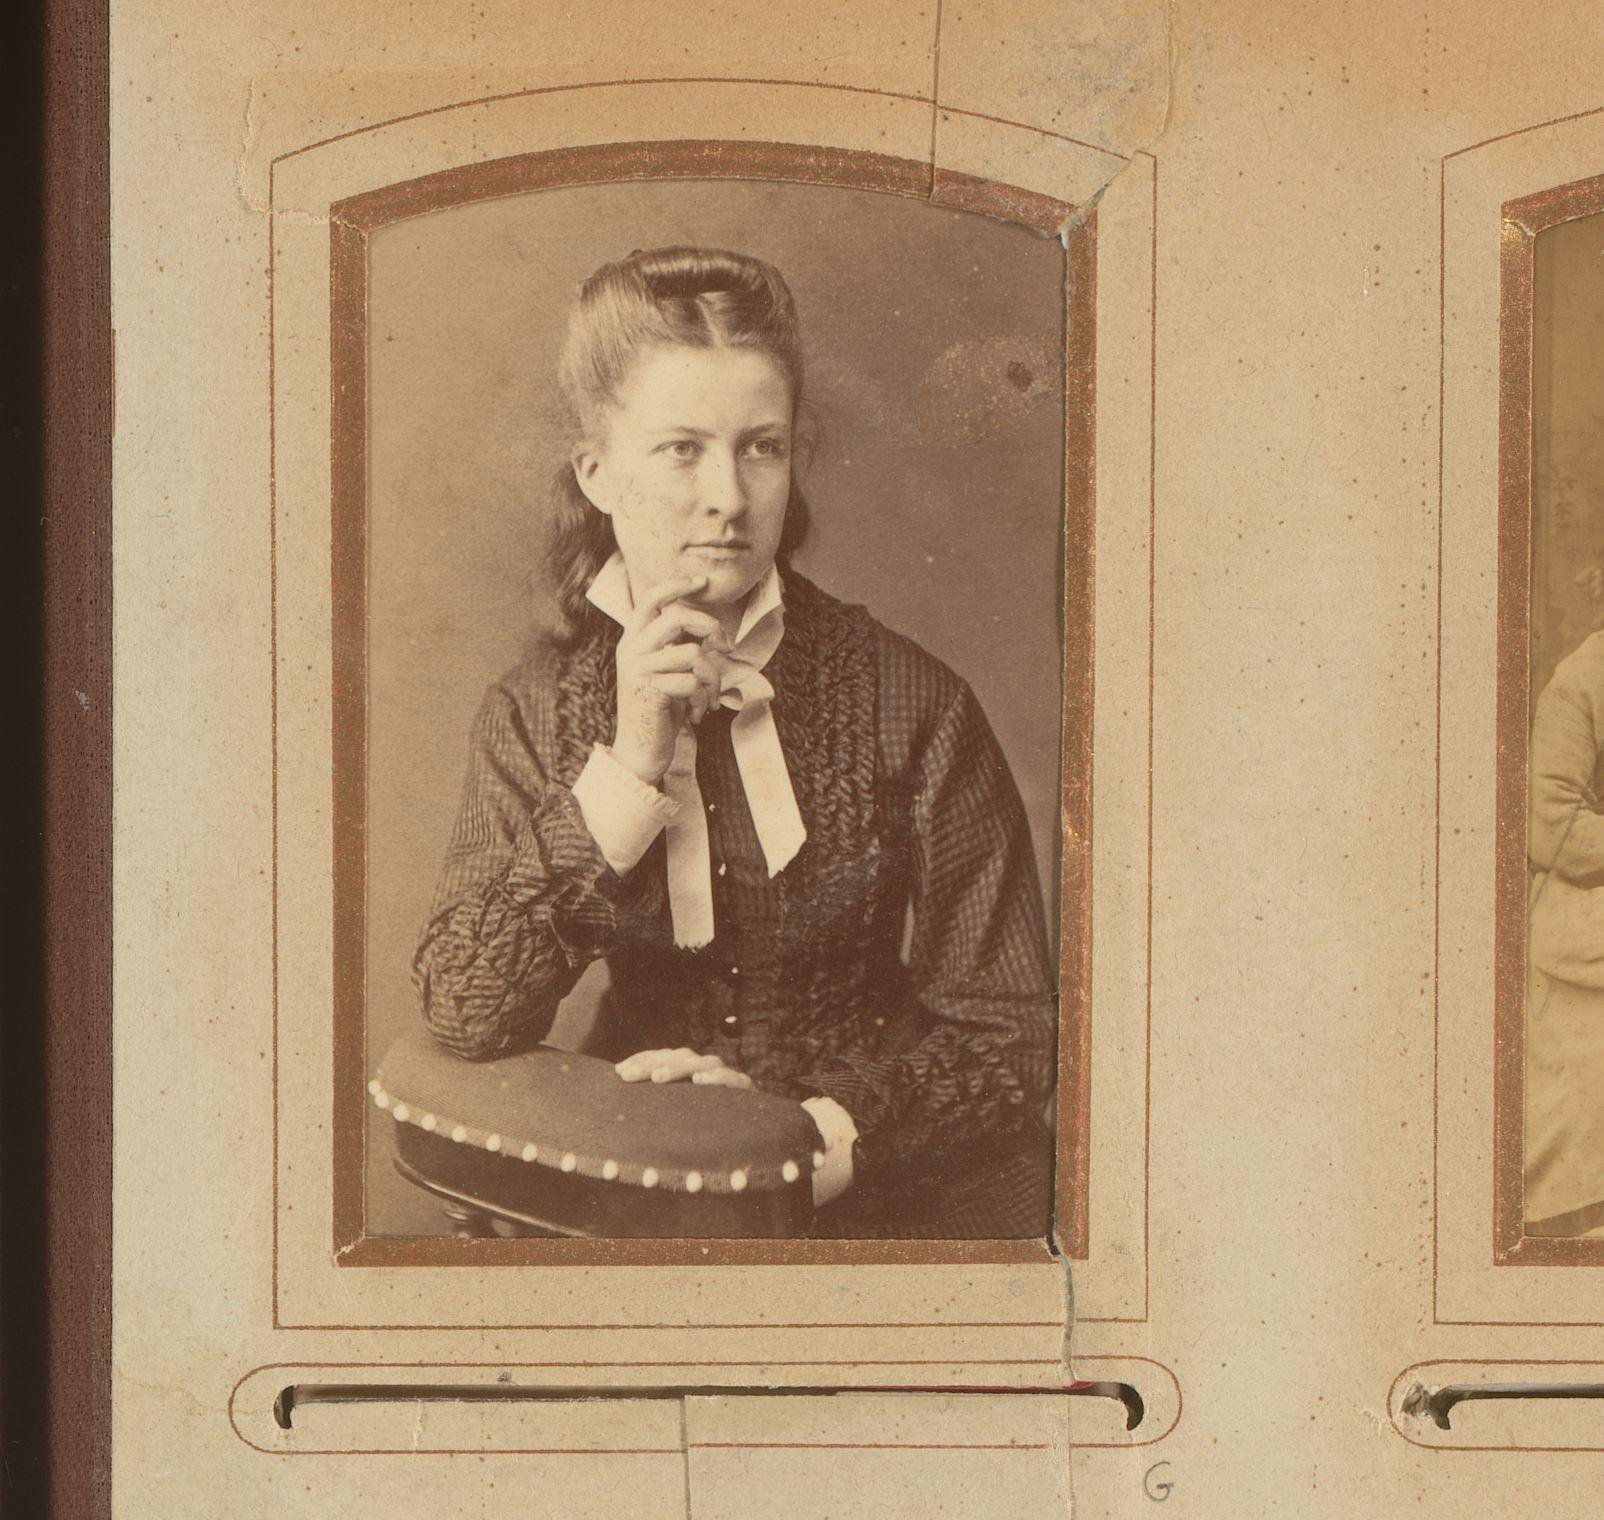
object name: photograph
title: Portret van een jonge zittende vrouw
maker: Anonymous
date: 1860-1900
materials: cardboard, photographic support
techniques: albumen print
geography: netherlands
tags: sitting figure - aa - female human figure, historical persons - bb - woman